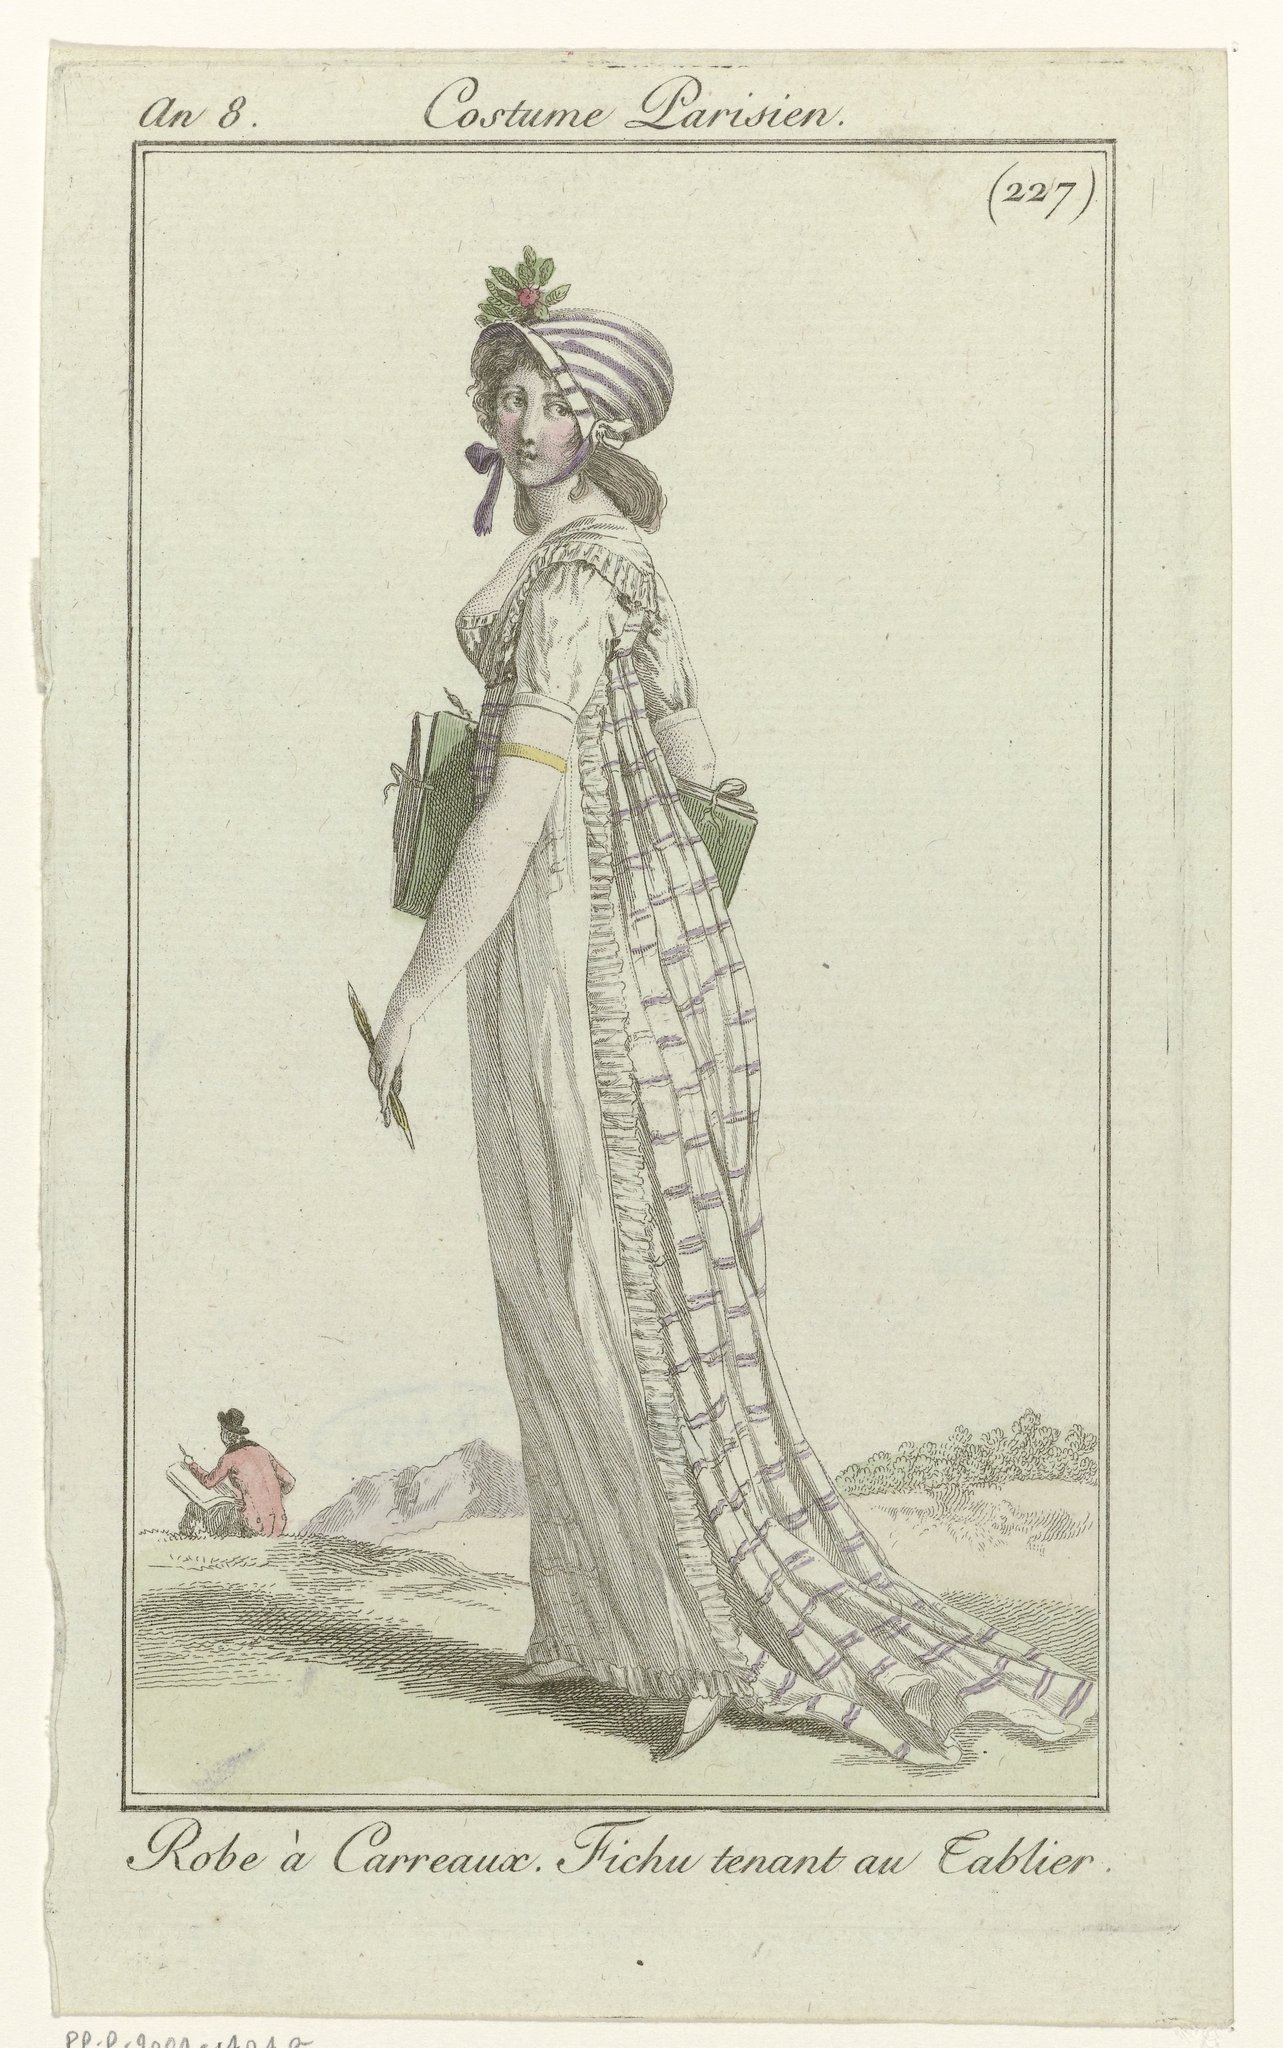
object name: fashion print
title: Journal des Dames et des Modes, Costume Parisien, 4 juillet 1800, An 8 (227) : Robe à Carreaux (...)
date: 1800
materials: paper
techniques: engraving, hand coloring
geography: paris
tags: drawing, sketch (+ painting, drawing, graphic arts), head-gear (+ women's clothes), fashion plates, shoes, sandals (+ women's clothes), dress, gown (+ women's clothes), apron (+ women's clothes), piece of clothing covering the breast or décolleté (fichu) (+ women's clothes)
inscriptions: title: ‘Costume Parisien.’, caption: ‘Robe à Carreaux. Fichu tenant au tablier.’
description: Geruite japon met korte mouwen en sleep. Fichu dat één geheel vormt met het schort, afgezet met een gerimpelde strook stof. Accessoires: gestreepte hoed, armband om de linker bovenarm, platte schoenen met puntige neuzen. De prent maakt deel uit van het modetijdschrift Journal des Dames et des Modes, uitgegeven door Pierre de la Mésangère, Parijs, 1797-1839.